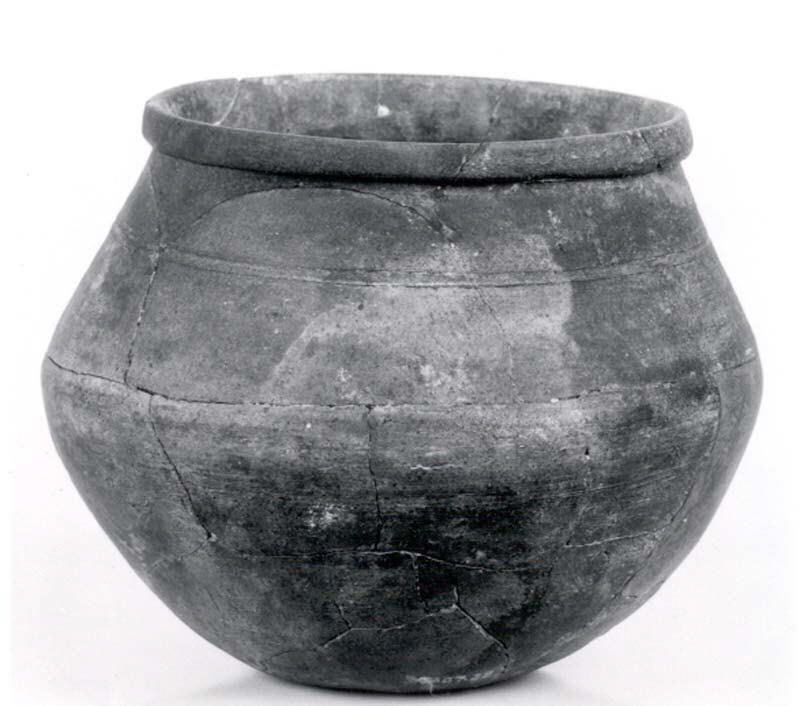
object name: pot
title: Cooking pot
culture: sasanian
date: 201-700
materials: ceramic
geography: iran